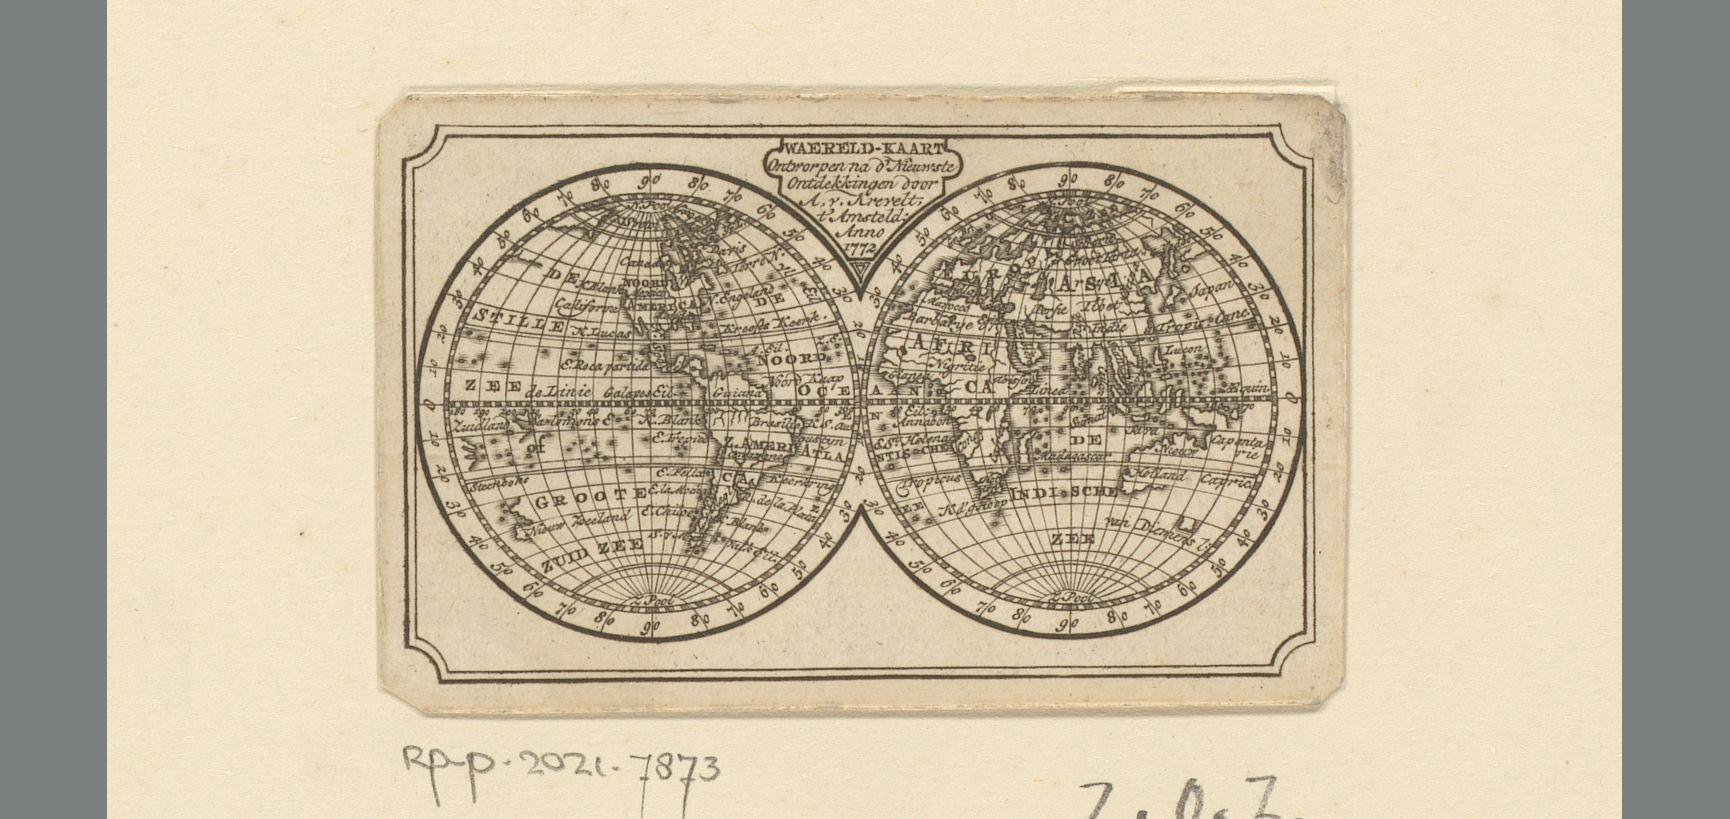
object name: visiting card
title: Visitekaart van graveur en kaartenmaker Abraham van Krevelt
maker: abraham van krevelt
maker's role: print maker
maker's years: 1732-1791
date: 1772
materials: paper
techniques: engraving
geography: amsterdam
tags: print maker, abraham van krevelt, map of the world, visiting-card, calling-card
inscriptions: date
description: Op de voorzijde een globe in twee helften met daarbij 'Waereld-kaart ontworpen na d' nieuwste ontdekkingen'. Op de achterzijde bedrijfsinformatie en adres van Van Krevelt.